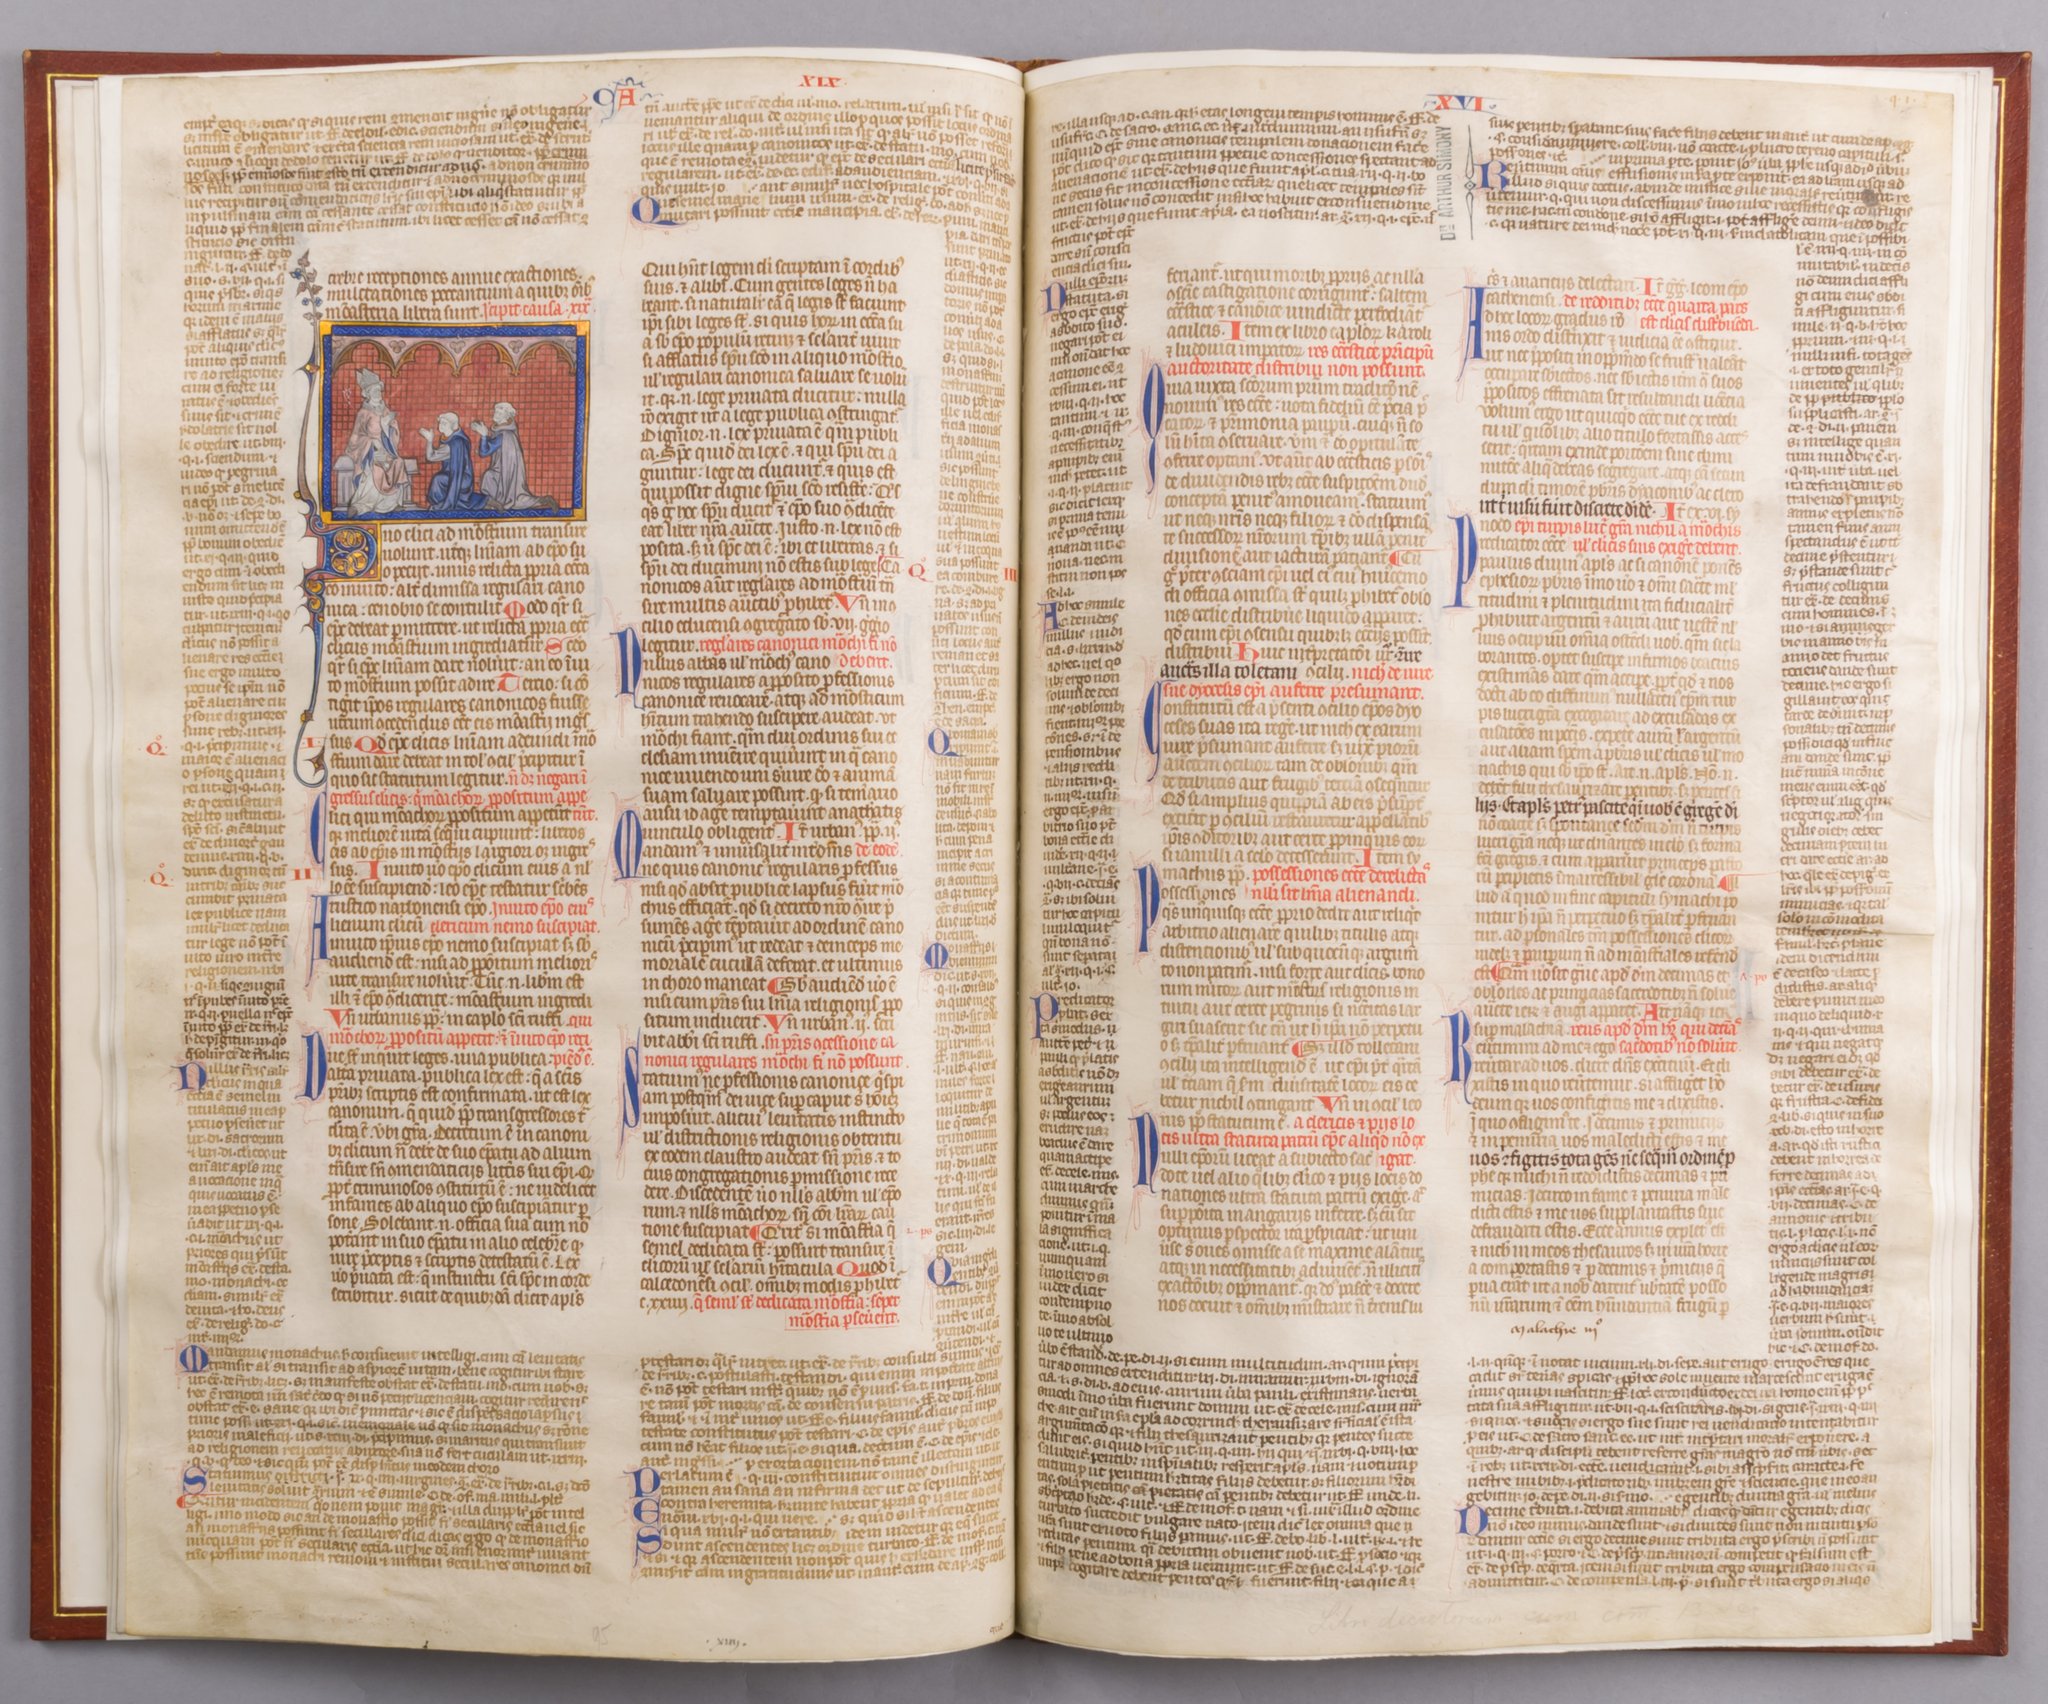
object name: bifolium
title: Bifolium with the Decretals of Gratian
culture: french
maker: master honore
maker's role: artist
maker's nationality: french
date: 1290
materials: gold, ink, leather, parchment, paint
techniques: bookbinding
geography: france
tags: men,bishops